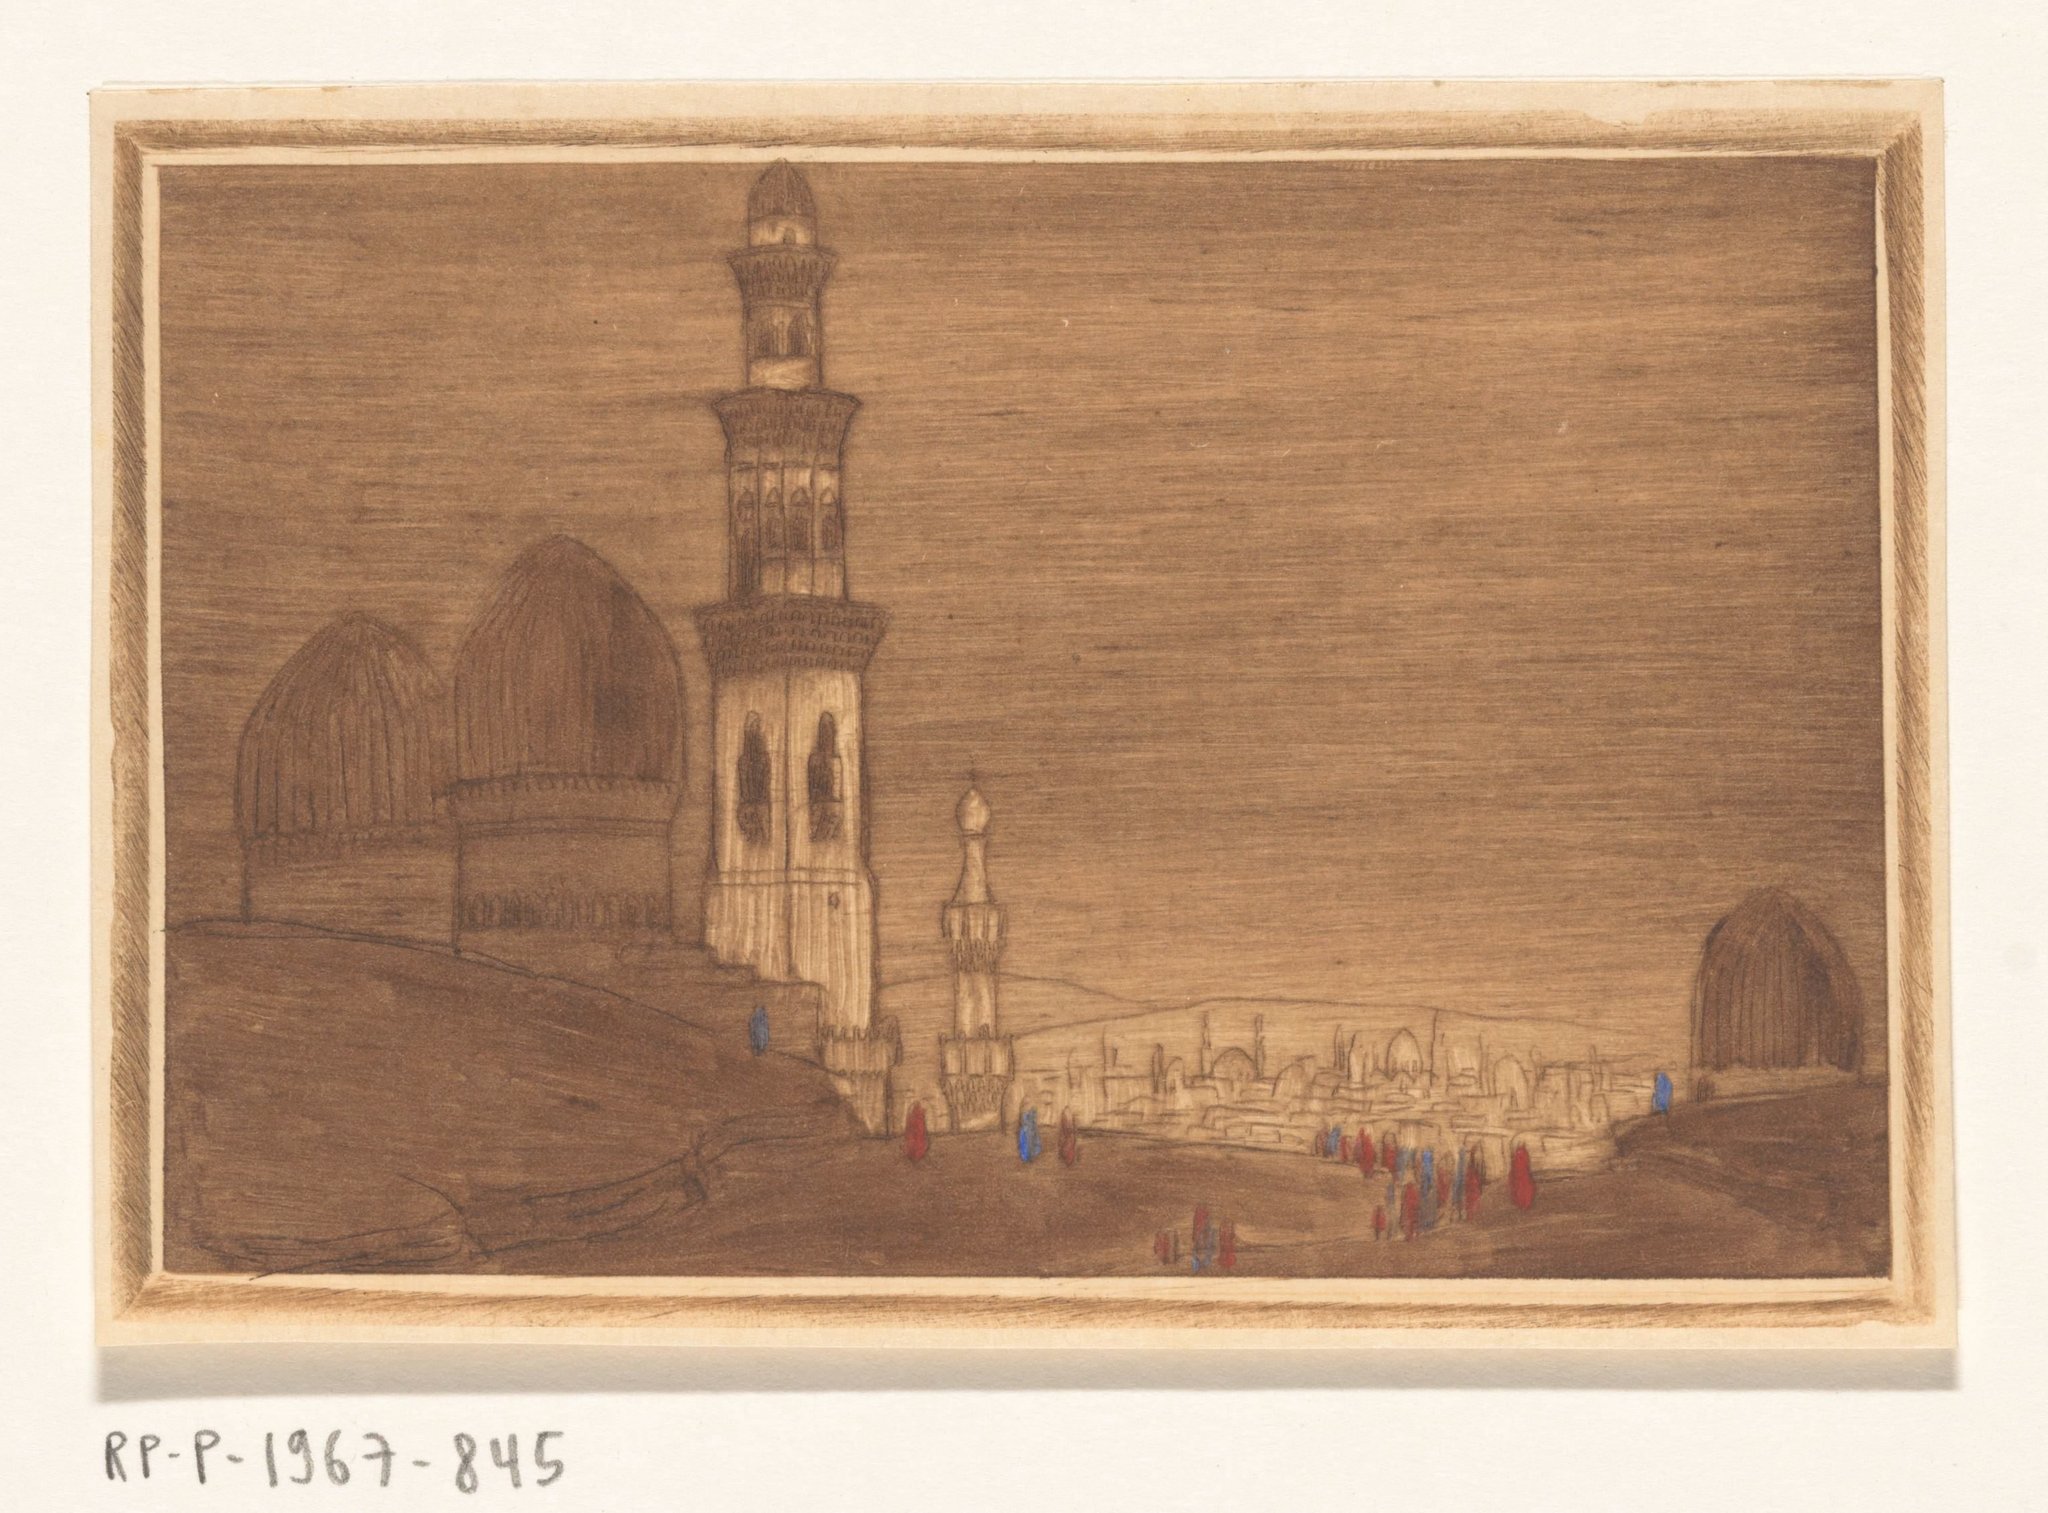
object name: print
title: Grafmoskee bij Caïro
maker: wijnand otto jan nieuwenkamp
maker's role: draughtsman, print maker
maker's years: 1874-1950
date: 1903-1912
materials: paper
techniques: drypoint, intaglio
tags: temple, shrine ~ islam, mohammedanism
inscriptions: collector's mark: Lugt 2760, collector's mark: Lugt 2228